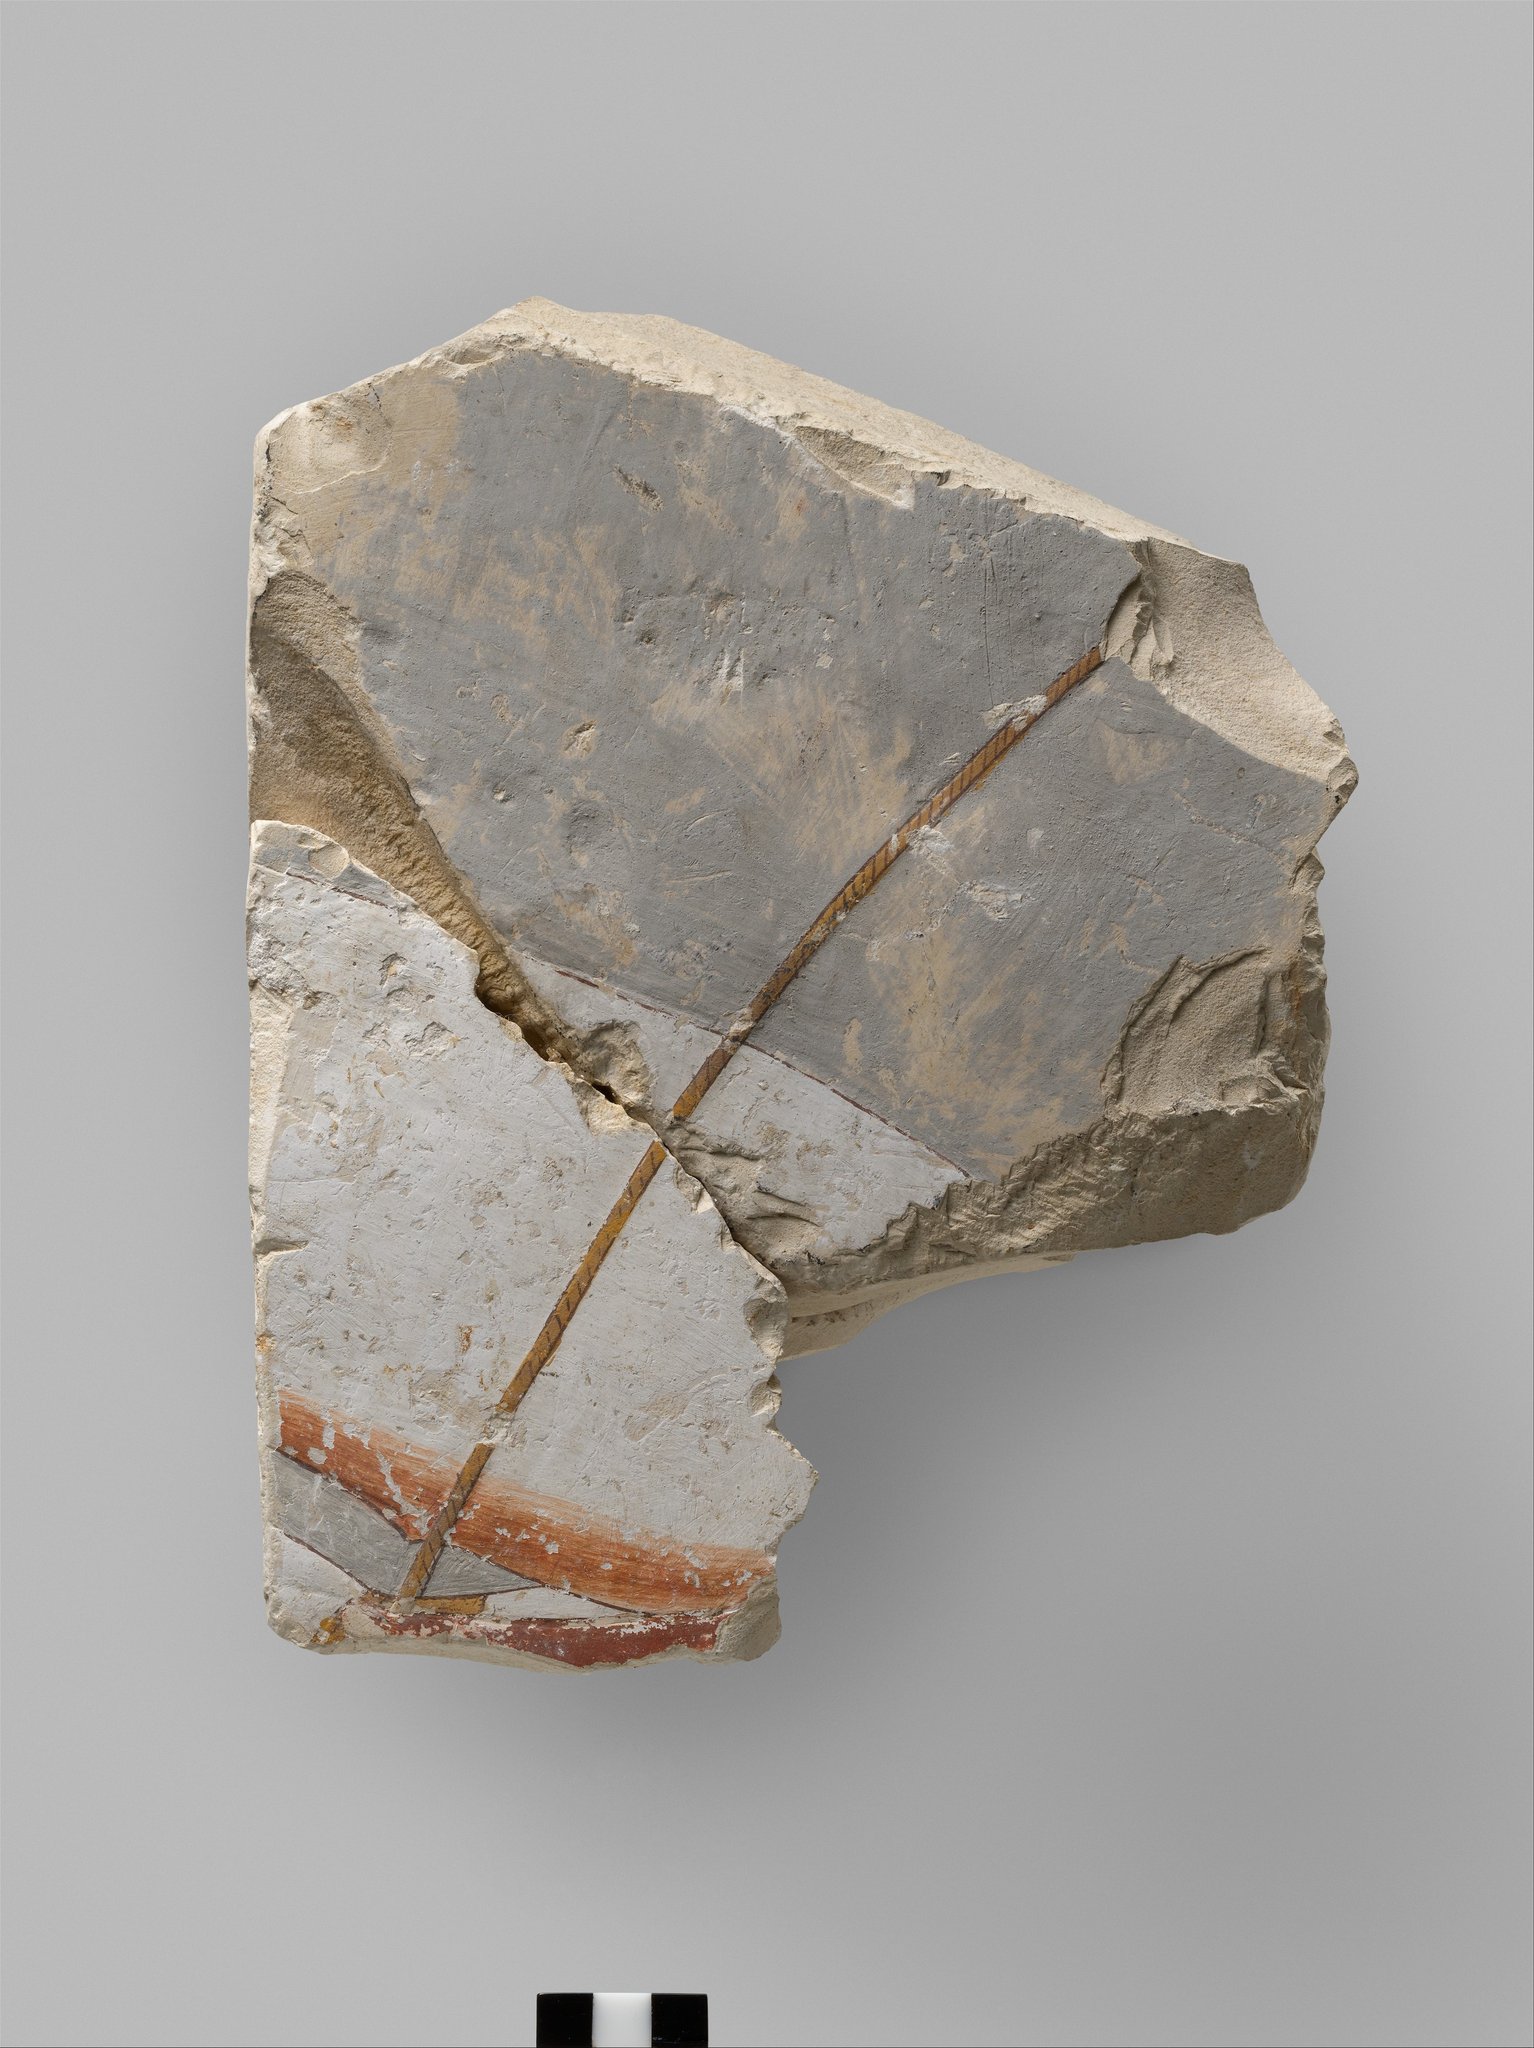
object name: relief fragment, tomb of meketre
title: Relief fragment from tomb of Meketre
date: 1981-1975 BCE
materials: limestone, paint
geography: egypt